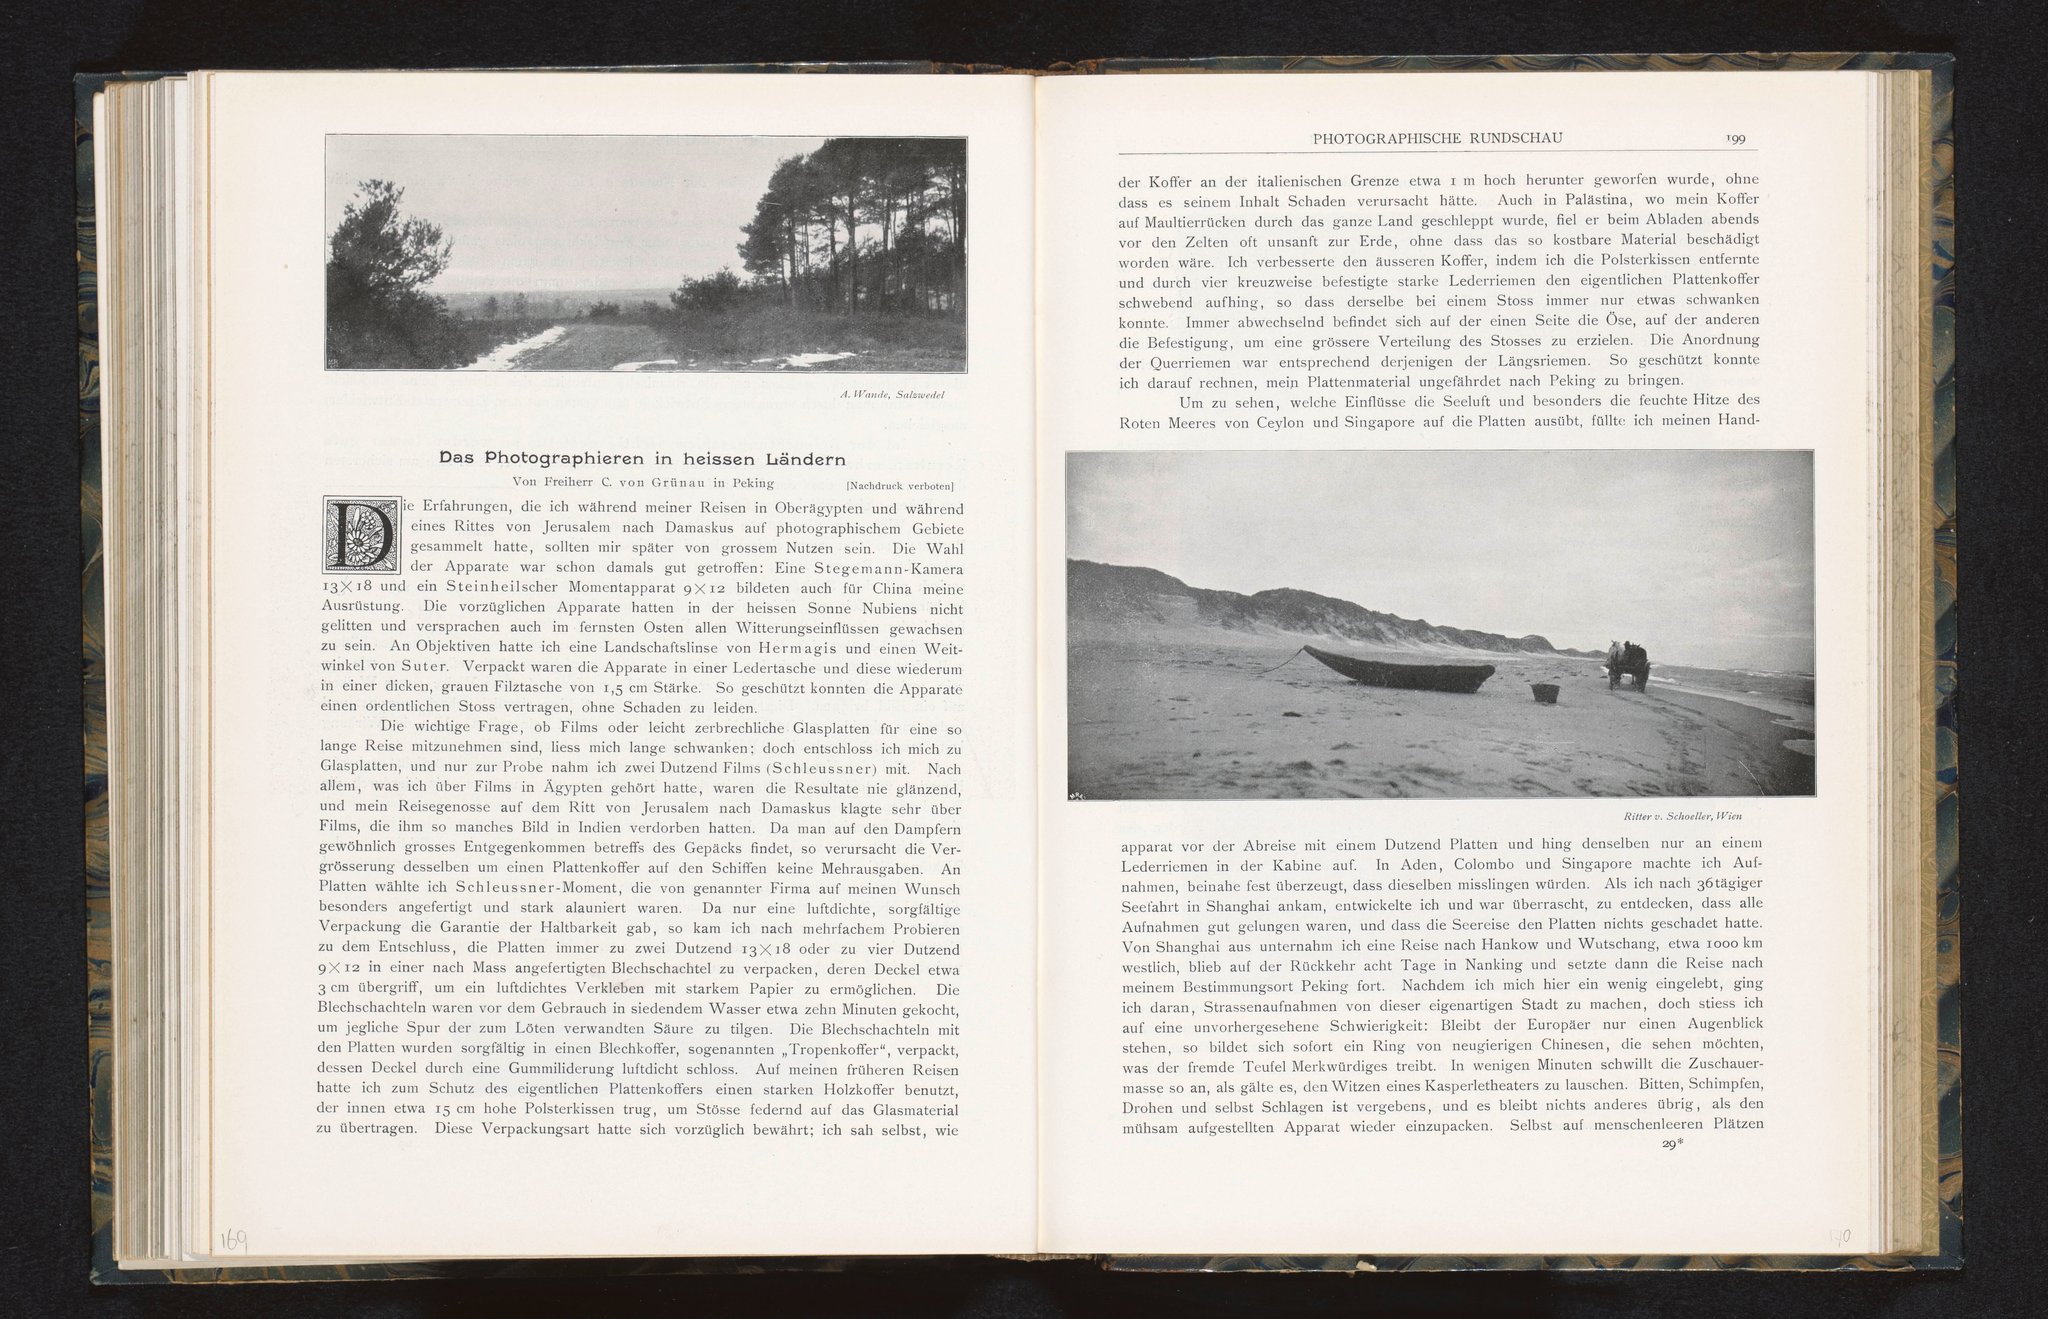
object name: page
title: Gezicht op een open plek in het bos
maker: a. wande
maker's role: fotograaf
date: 1895-1900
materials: paper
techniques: autotype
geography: berlin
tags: trees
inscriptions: monogram: ‘MR/ &Co’